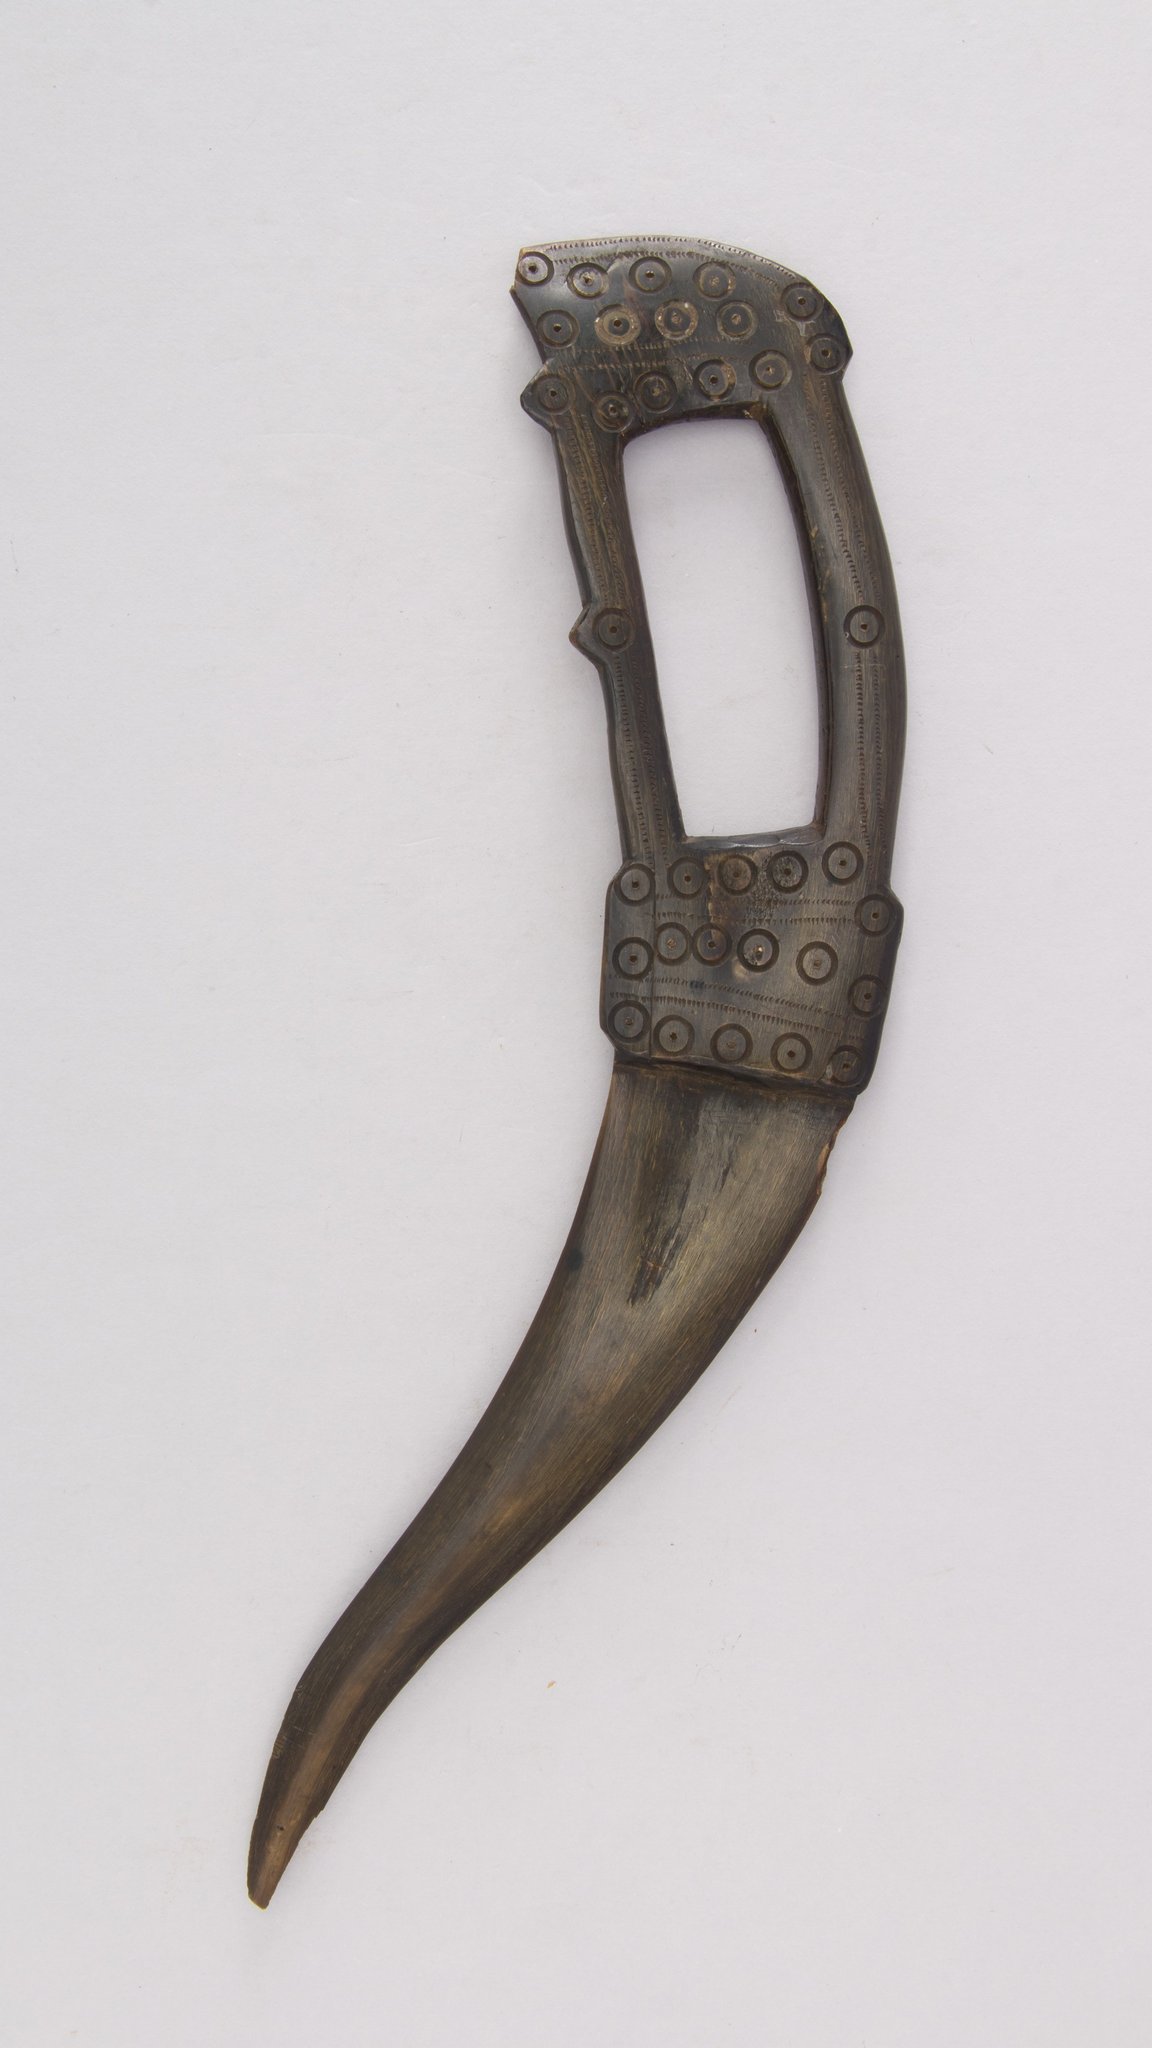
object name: dagger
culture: indian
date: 1701-1900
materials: horn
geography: central india